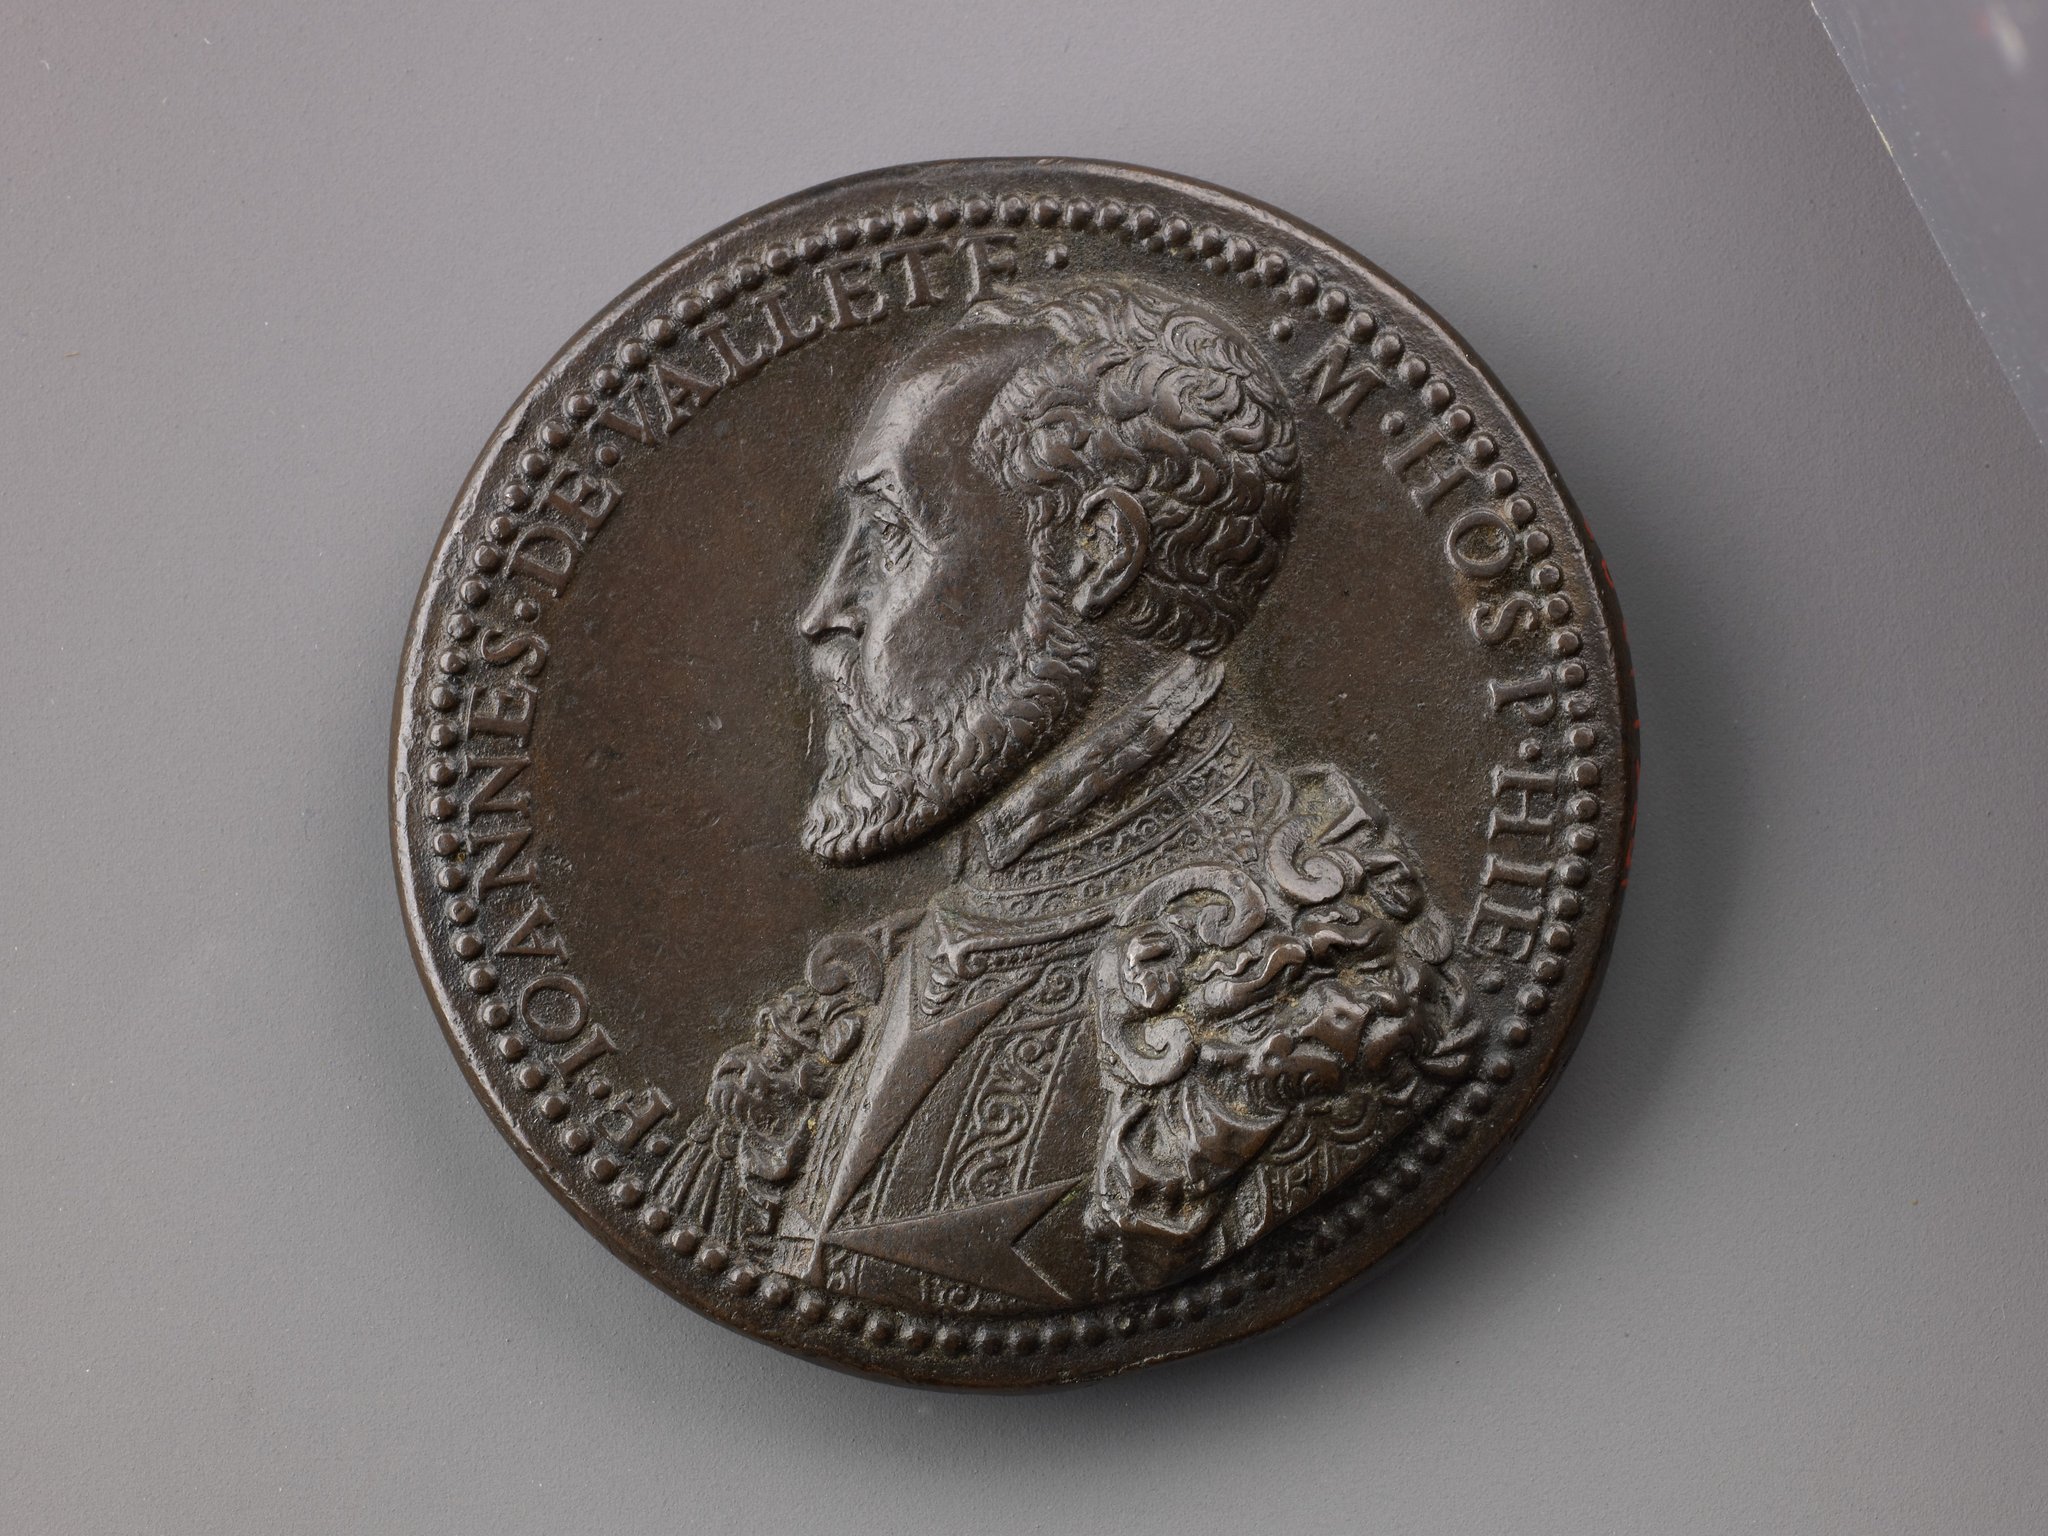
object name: medal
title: Jean Parisot de la Vallette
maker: mario d'aluigi ("marius")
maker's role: artist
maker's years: 1612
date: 1566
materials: copper alloy, patina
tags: men,elephants